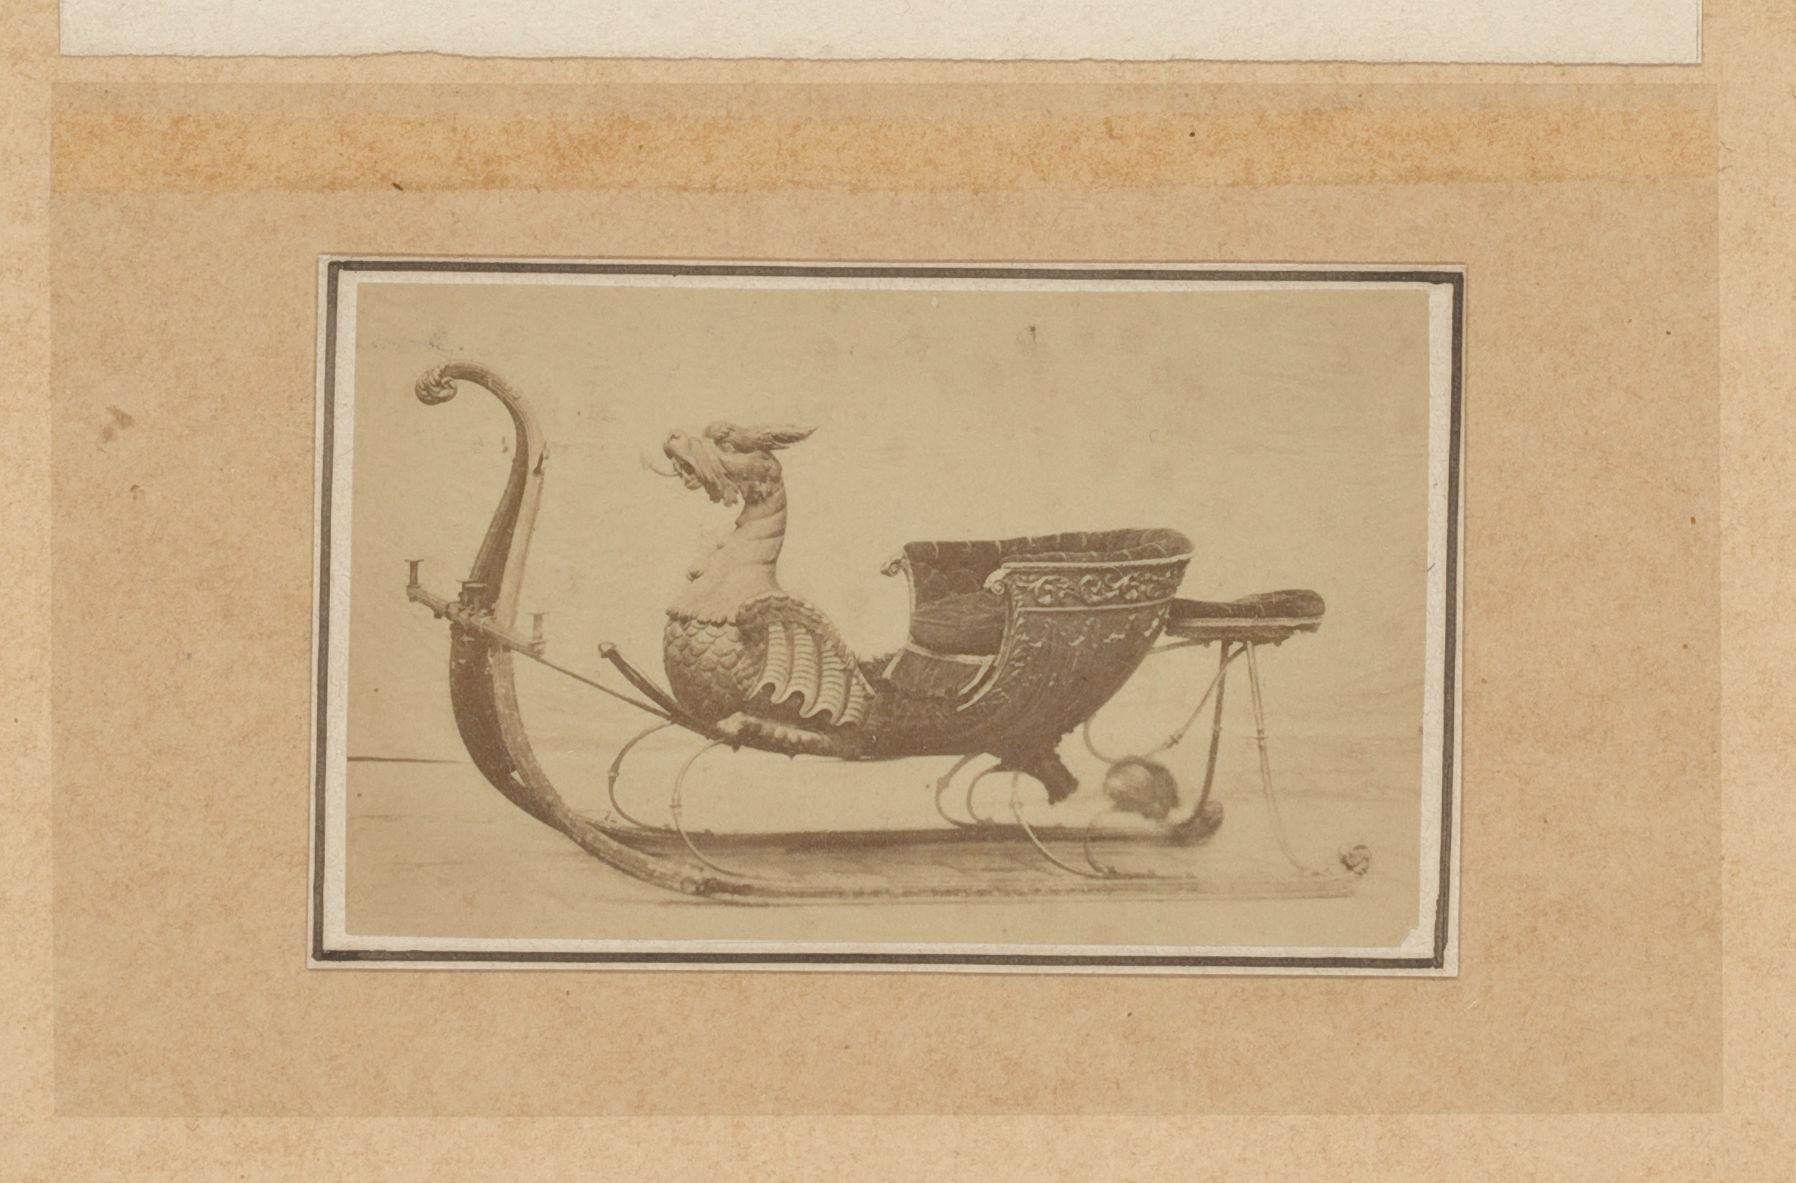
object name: photograph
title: Arrenslee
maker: Anonymous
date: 1860-1910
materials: photographic support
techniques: albumen print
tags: griffin (lion/eagle); 'griffo' (ripa), horse-sleigh, winter sports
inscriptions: collector's mark, collector's mark: Lugt 1641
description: Arrenslee met ornament in de vorm van een griffioen of draak. Onderwerpsrubrieken binnen de Atlas Zeden en Gewoonten: Spel en Vermaak; IJsvermaak, Sleden.